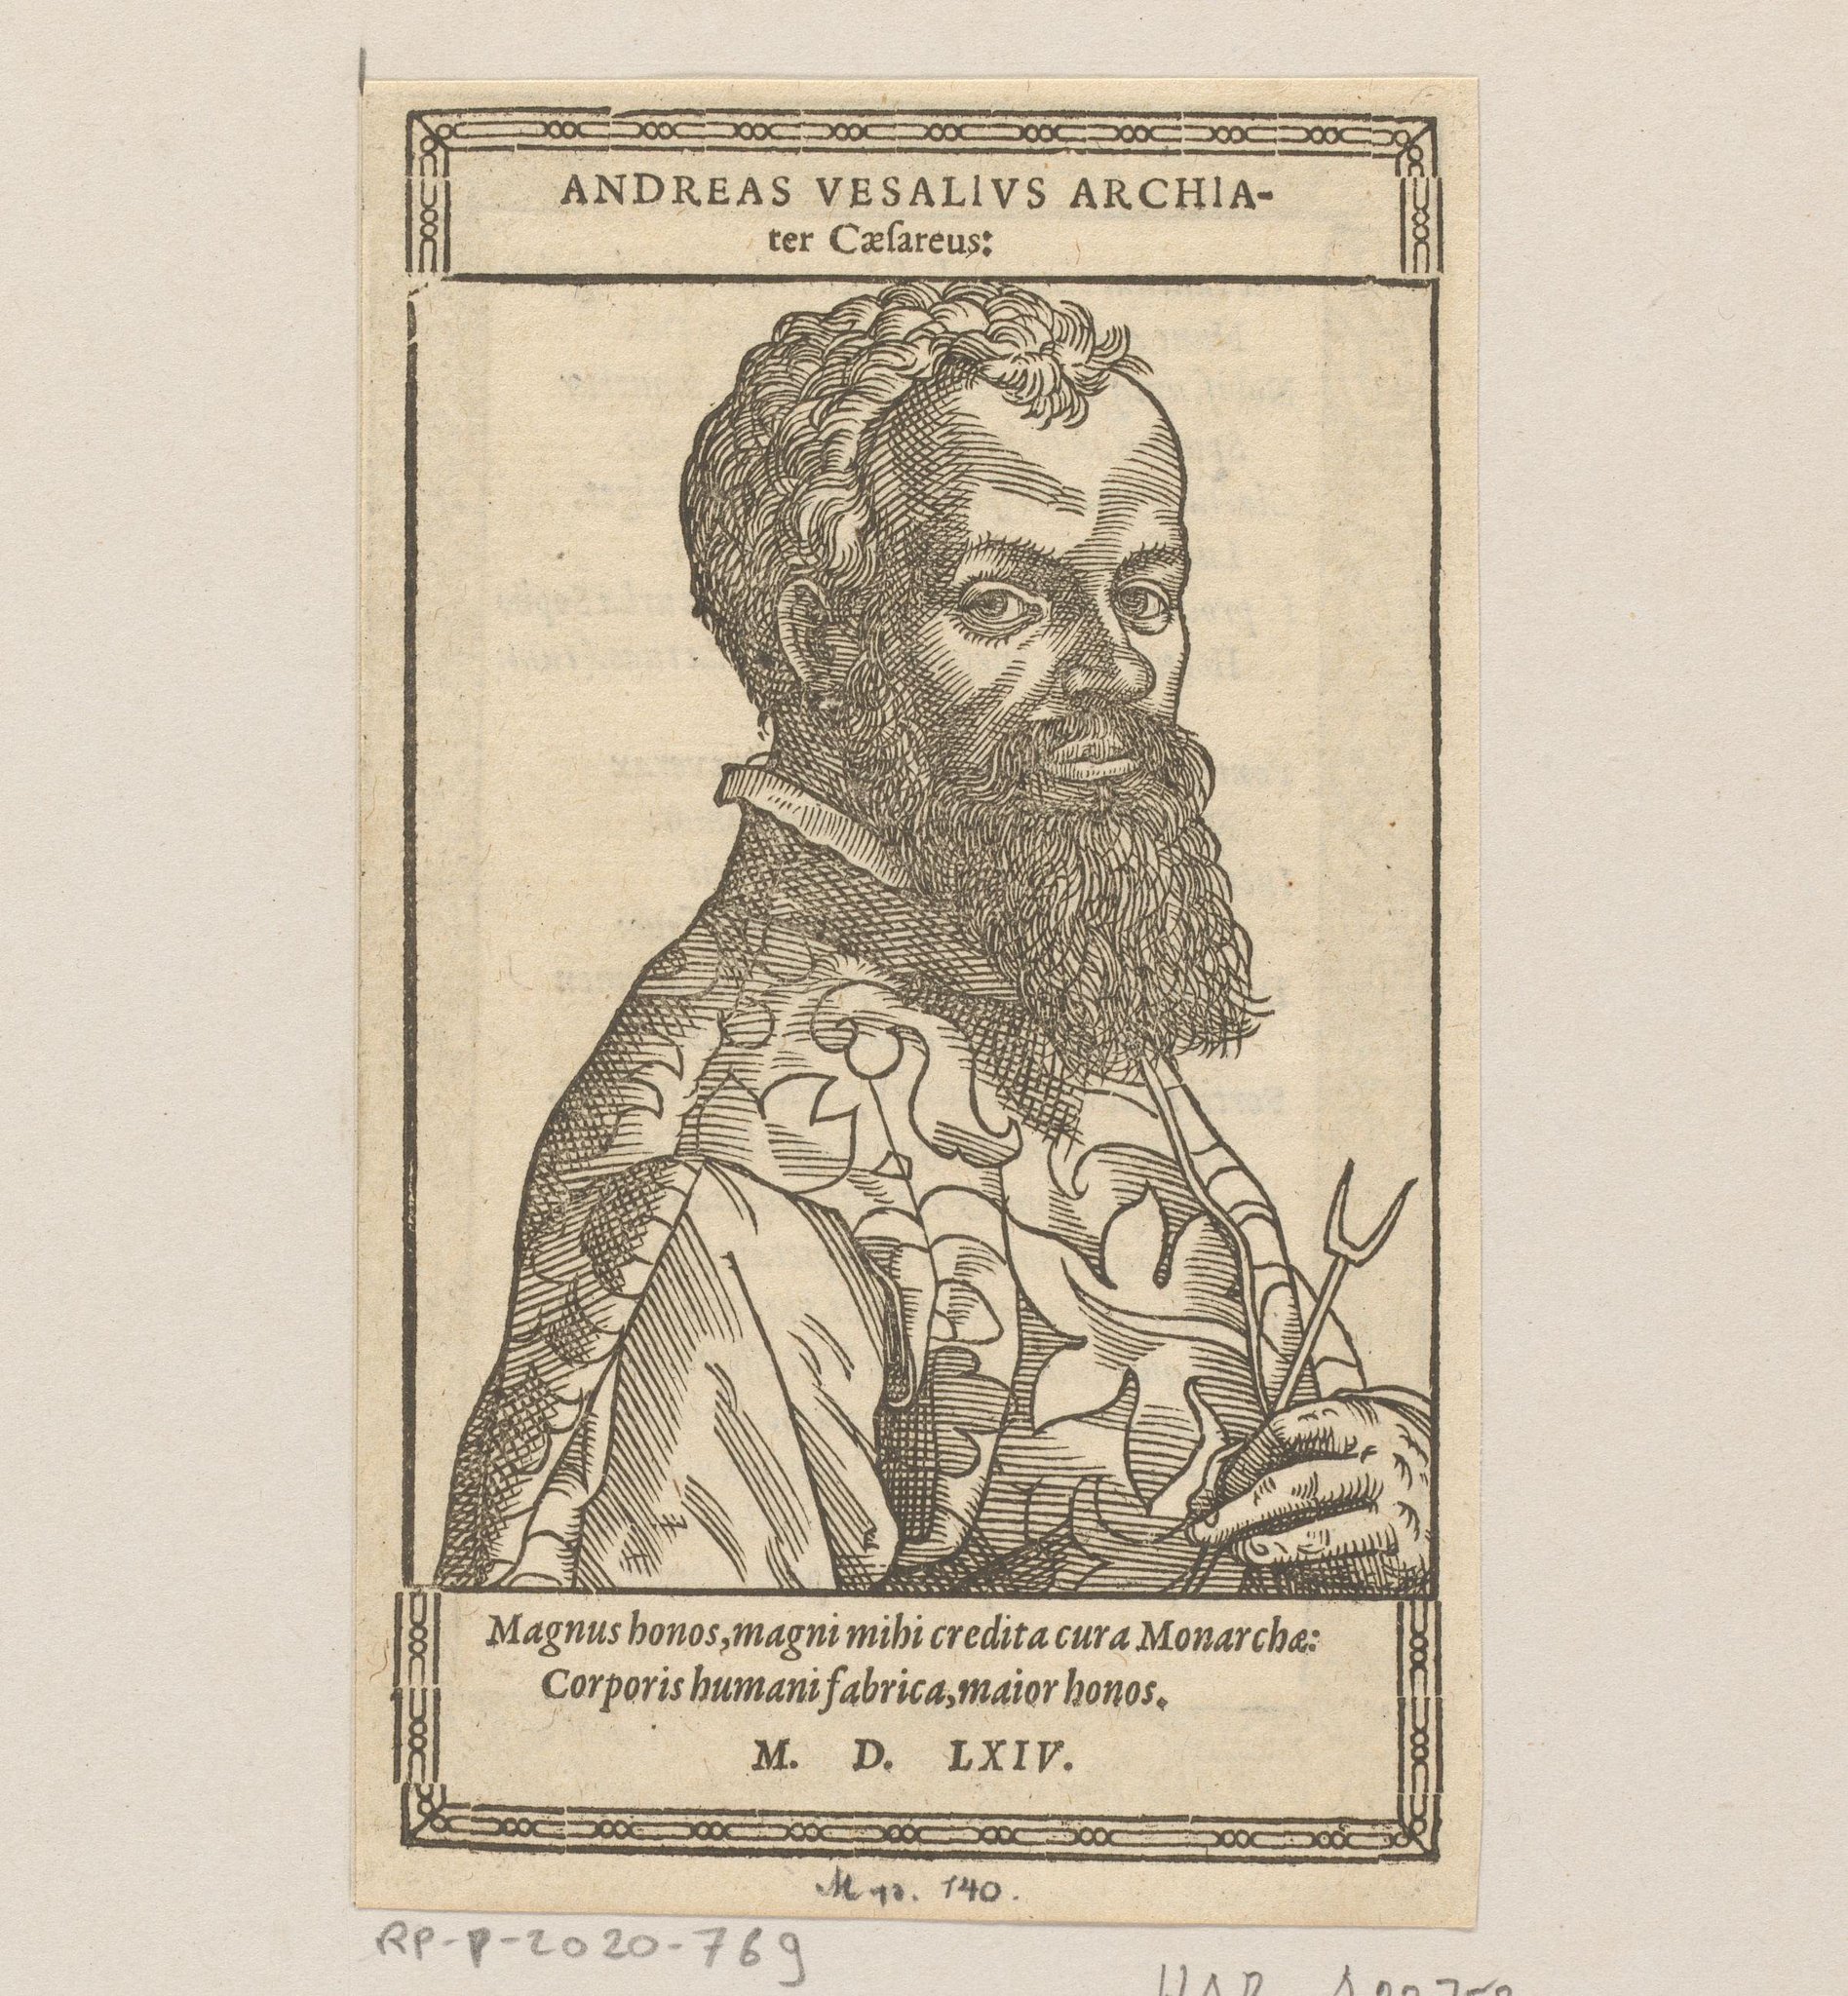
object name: book illustration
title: Portret van Andreas Vesalius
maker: bernhard jobin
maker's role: printer, publisher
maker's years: 1545-1593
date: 1587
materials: paper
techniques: letterpress printing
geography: straatsburg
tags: brussels, historical persons, physician, doctor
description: Prent uit: Reusner, Nikolaus. Icones sive imagines virorum literis illustrium (...). Straatsburg: Bernhard Jobin, 1587. Prent ook gebruikt in de Duitse editie, uitgegeven in hetzelfde jaar, en de 1590-editie. Prent ook gebruikt in latere publicaties.